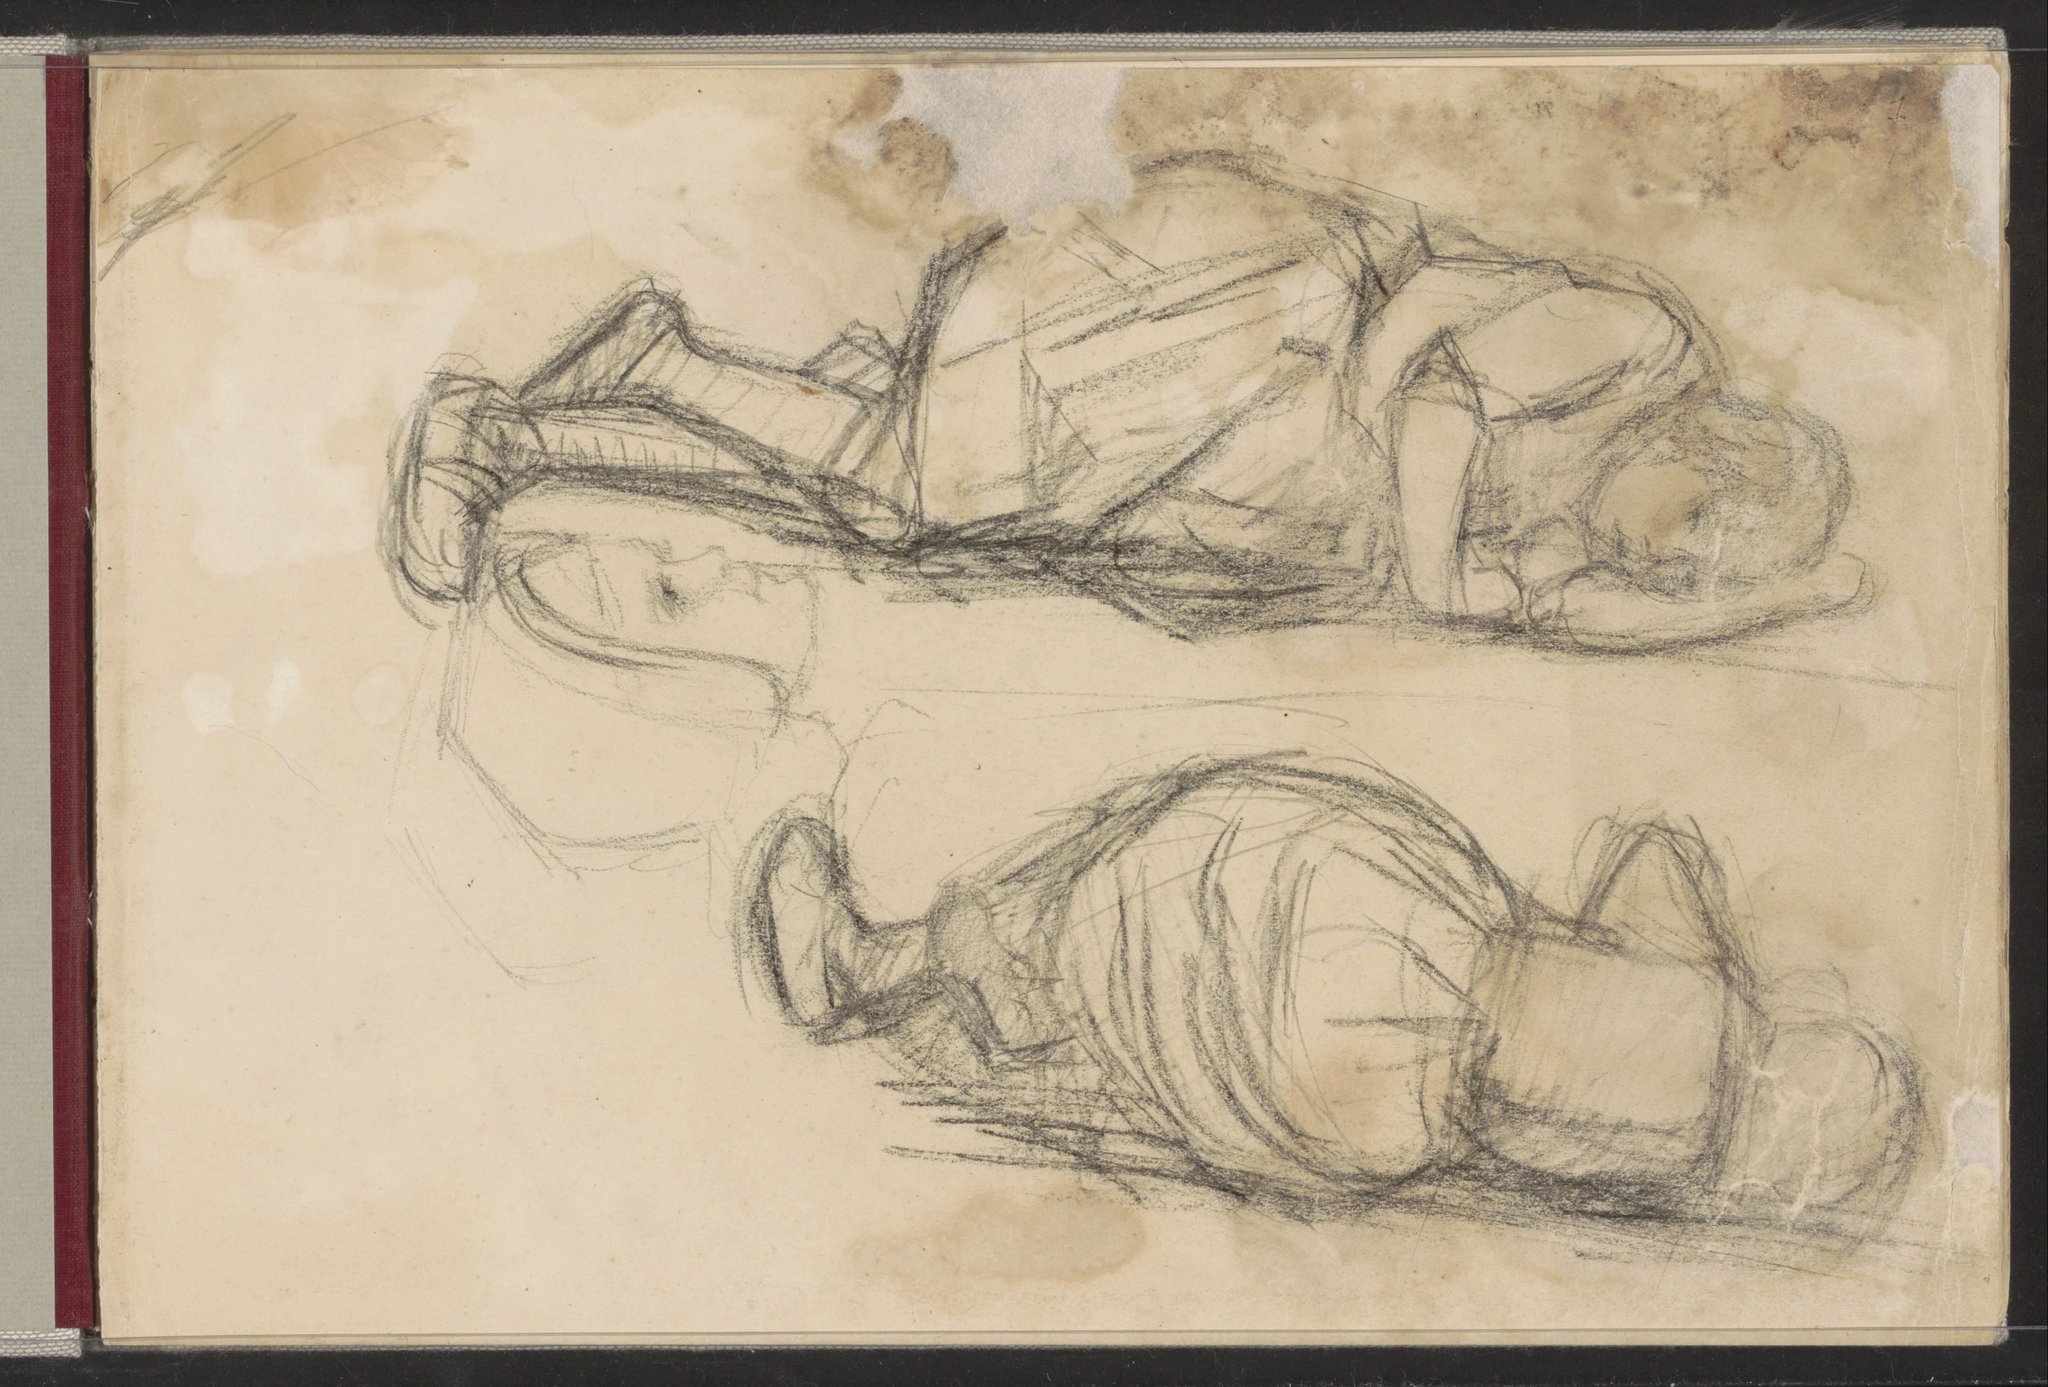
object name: sketchbook leaf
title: Liggend meisje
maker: jozef israëls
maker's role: draughtsman, painter, print maker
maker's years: 1824-1911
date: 1834-1911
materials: chalk, paper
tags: head (human), lying figure - aa - female human figure (+ young female (human being))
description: Het meisje ligt in haar kleding met haar knieën opgetrokken en ondersteunt haar hoofd met haar arm. Tevens een studie van een kop. Blad 1 recto uit een schetsboek met 30 bladen.